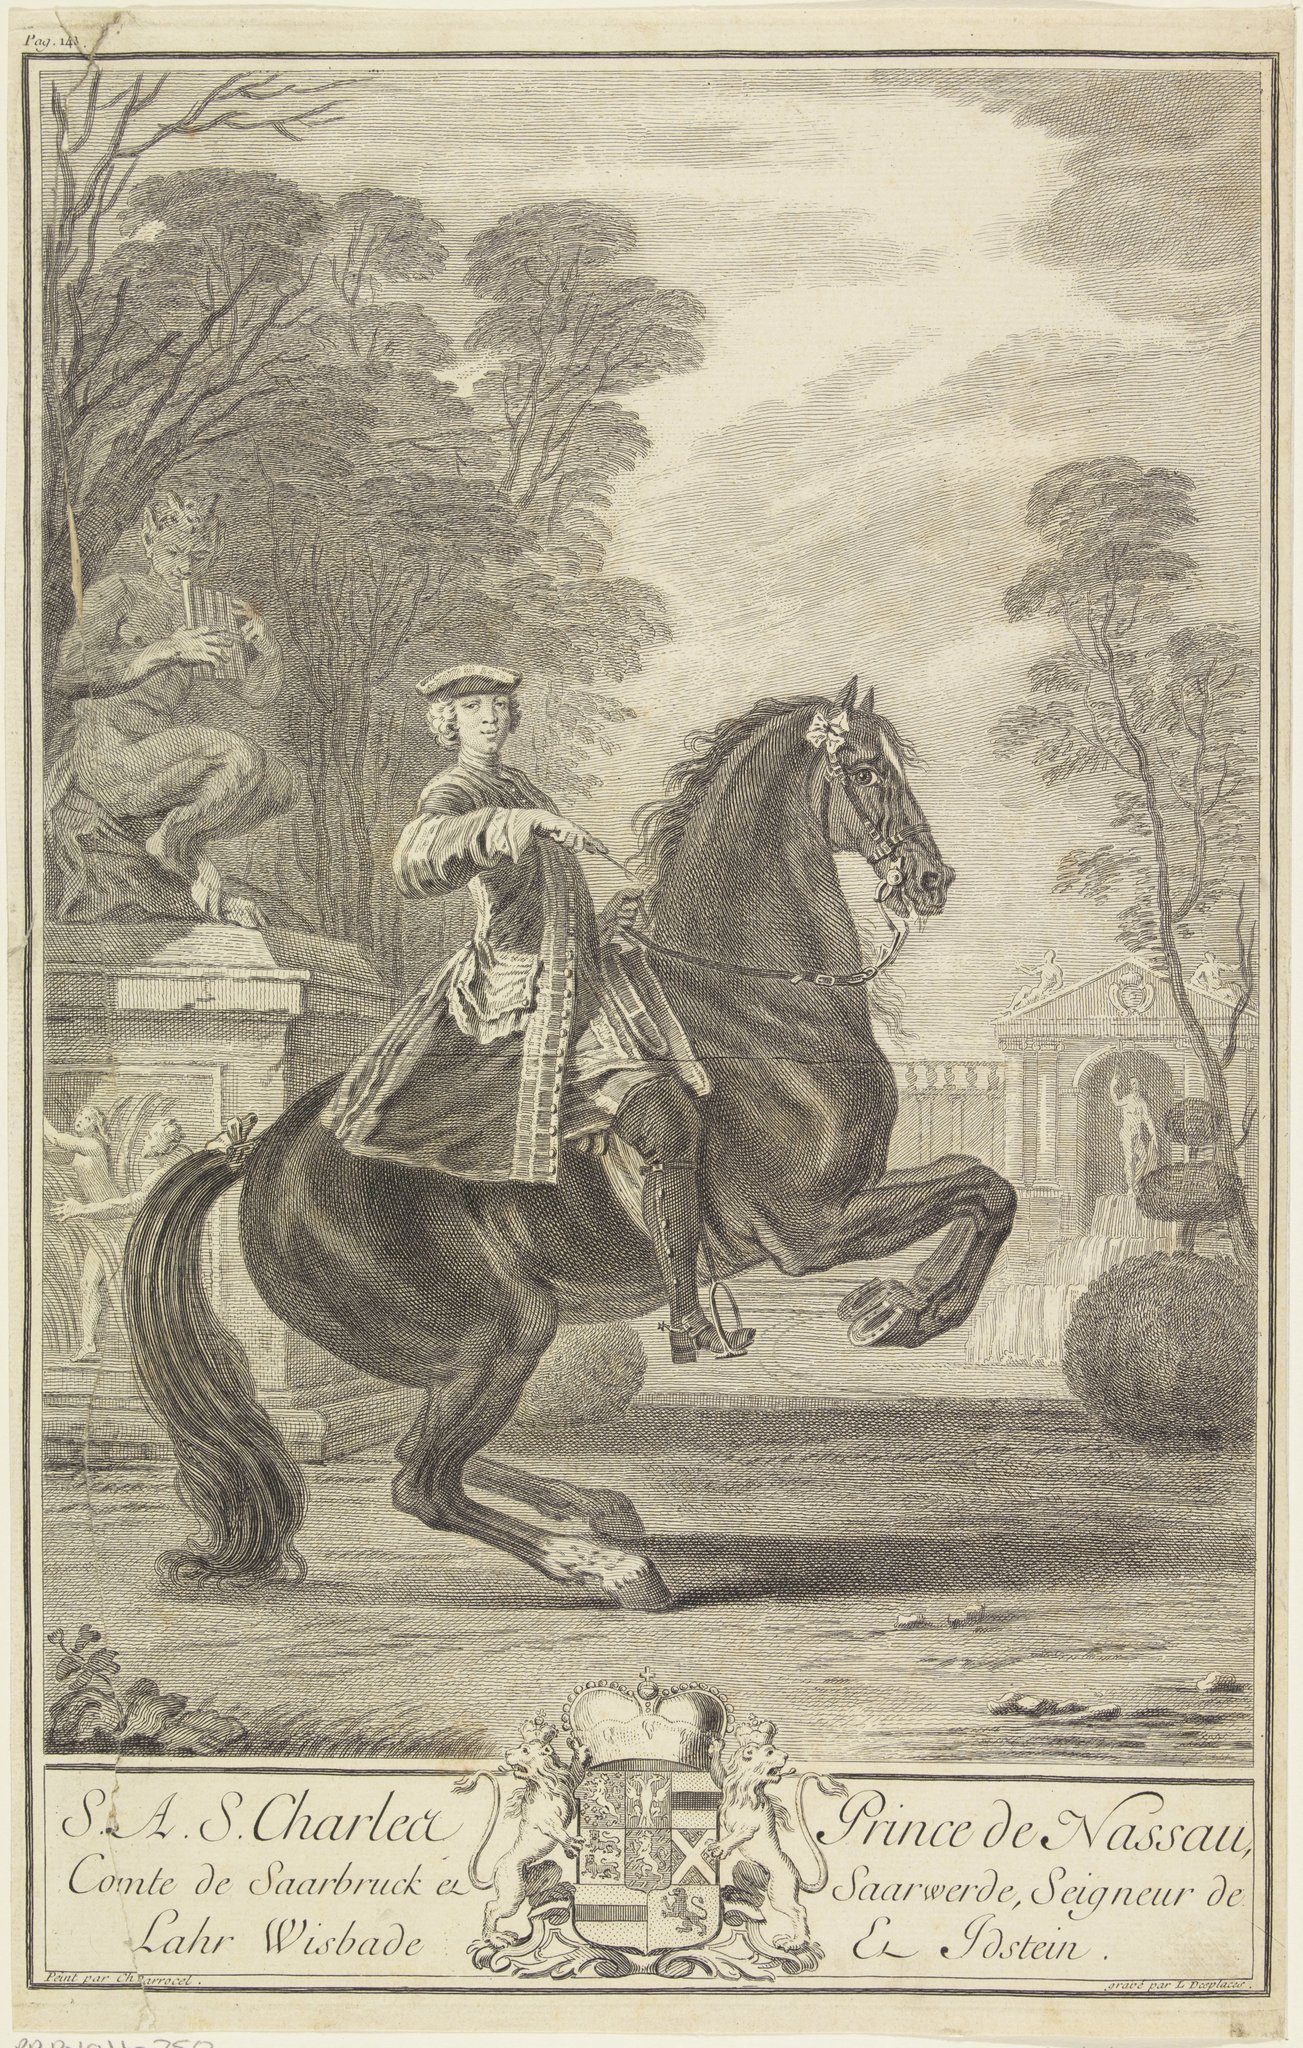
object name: book illustration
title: Ruiterportret van Karel van Nassau-Usingen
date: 1692-1739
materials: paper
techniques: engraving, etching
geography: france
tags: usingen, karel van nassau-usingen, huis nassau walramse linie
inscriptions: collector's mark: Lugt 2228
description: Ruiterportret van Karel. Midden onder zijn wapen met een kroon en twee leeuwen. In een kader zijn naam en titels. Linksboven 'Pag. 143.'.